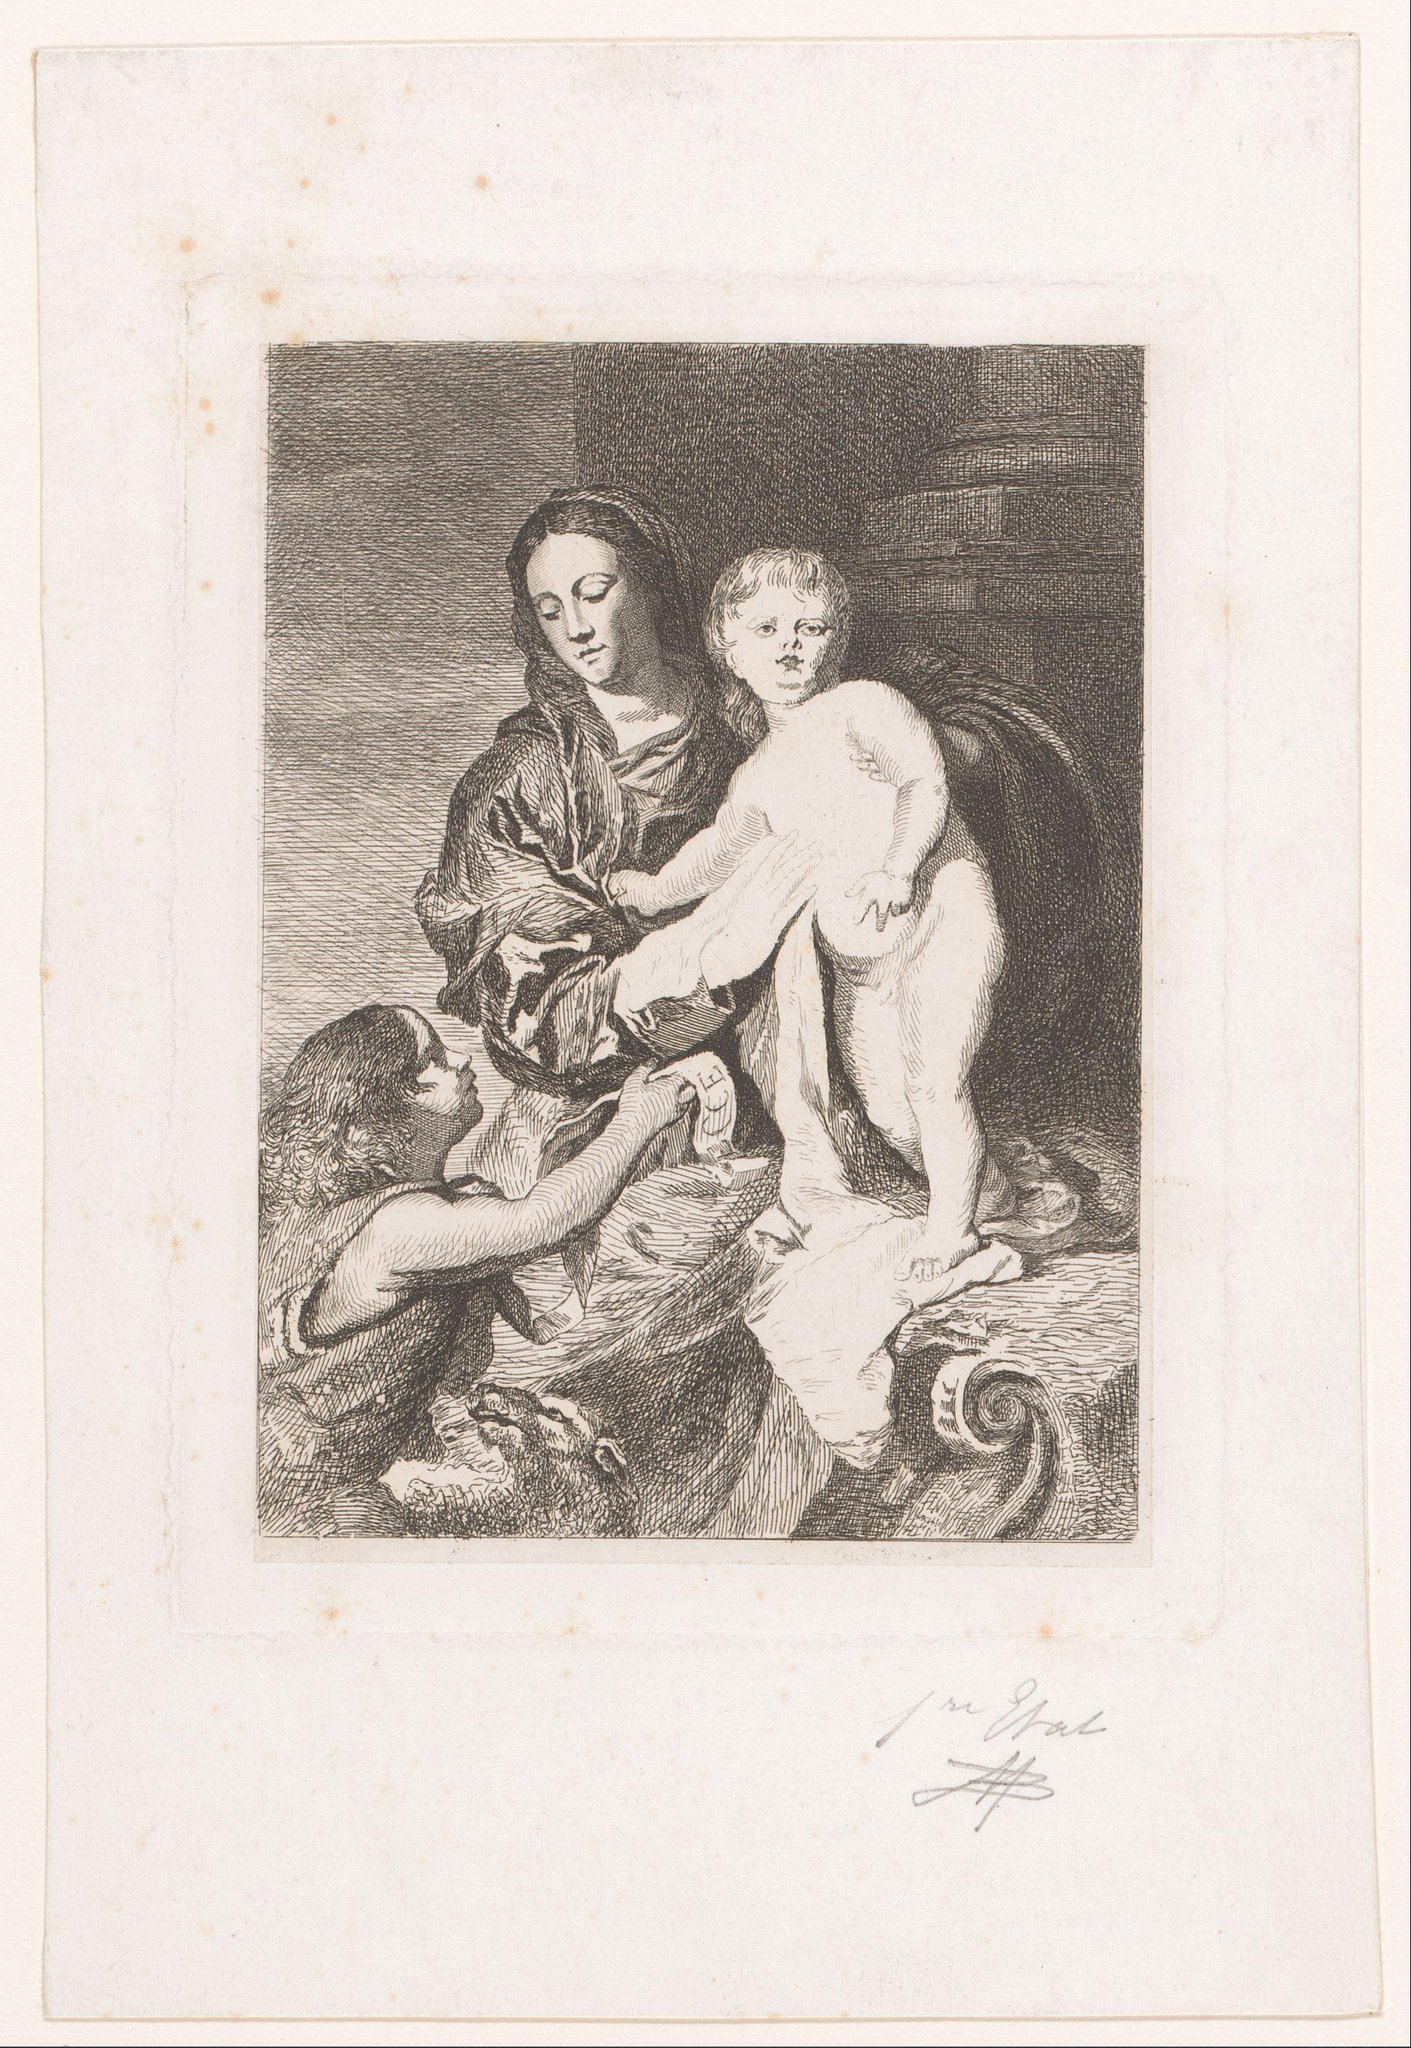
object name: print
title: Maria met het Christuskind en de jonge Johannes de Doper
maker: jean baptiste pierre michiels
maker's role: print maker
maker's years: 1821-1890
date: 1831-1890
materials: paper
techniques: etching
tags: mary and the christ-child with john the baptist (as child)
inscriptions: collector's mark: Lugt 2228, inscription: ‘1m Etat’